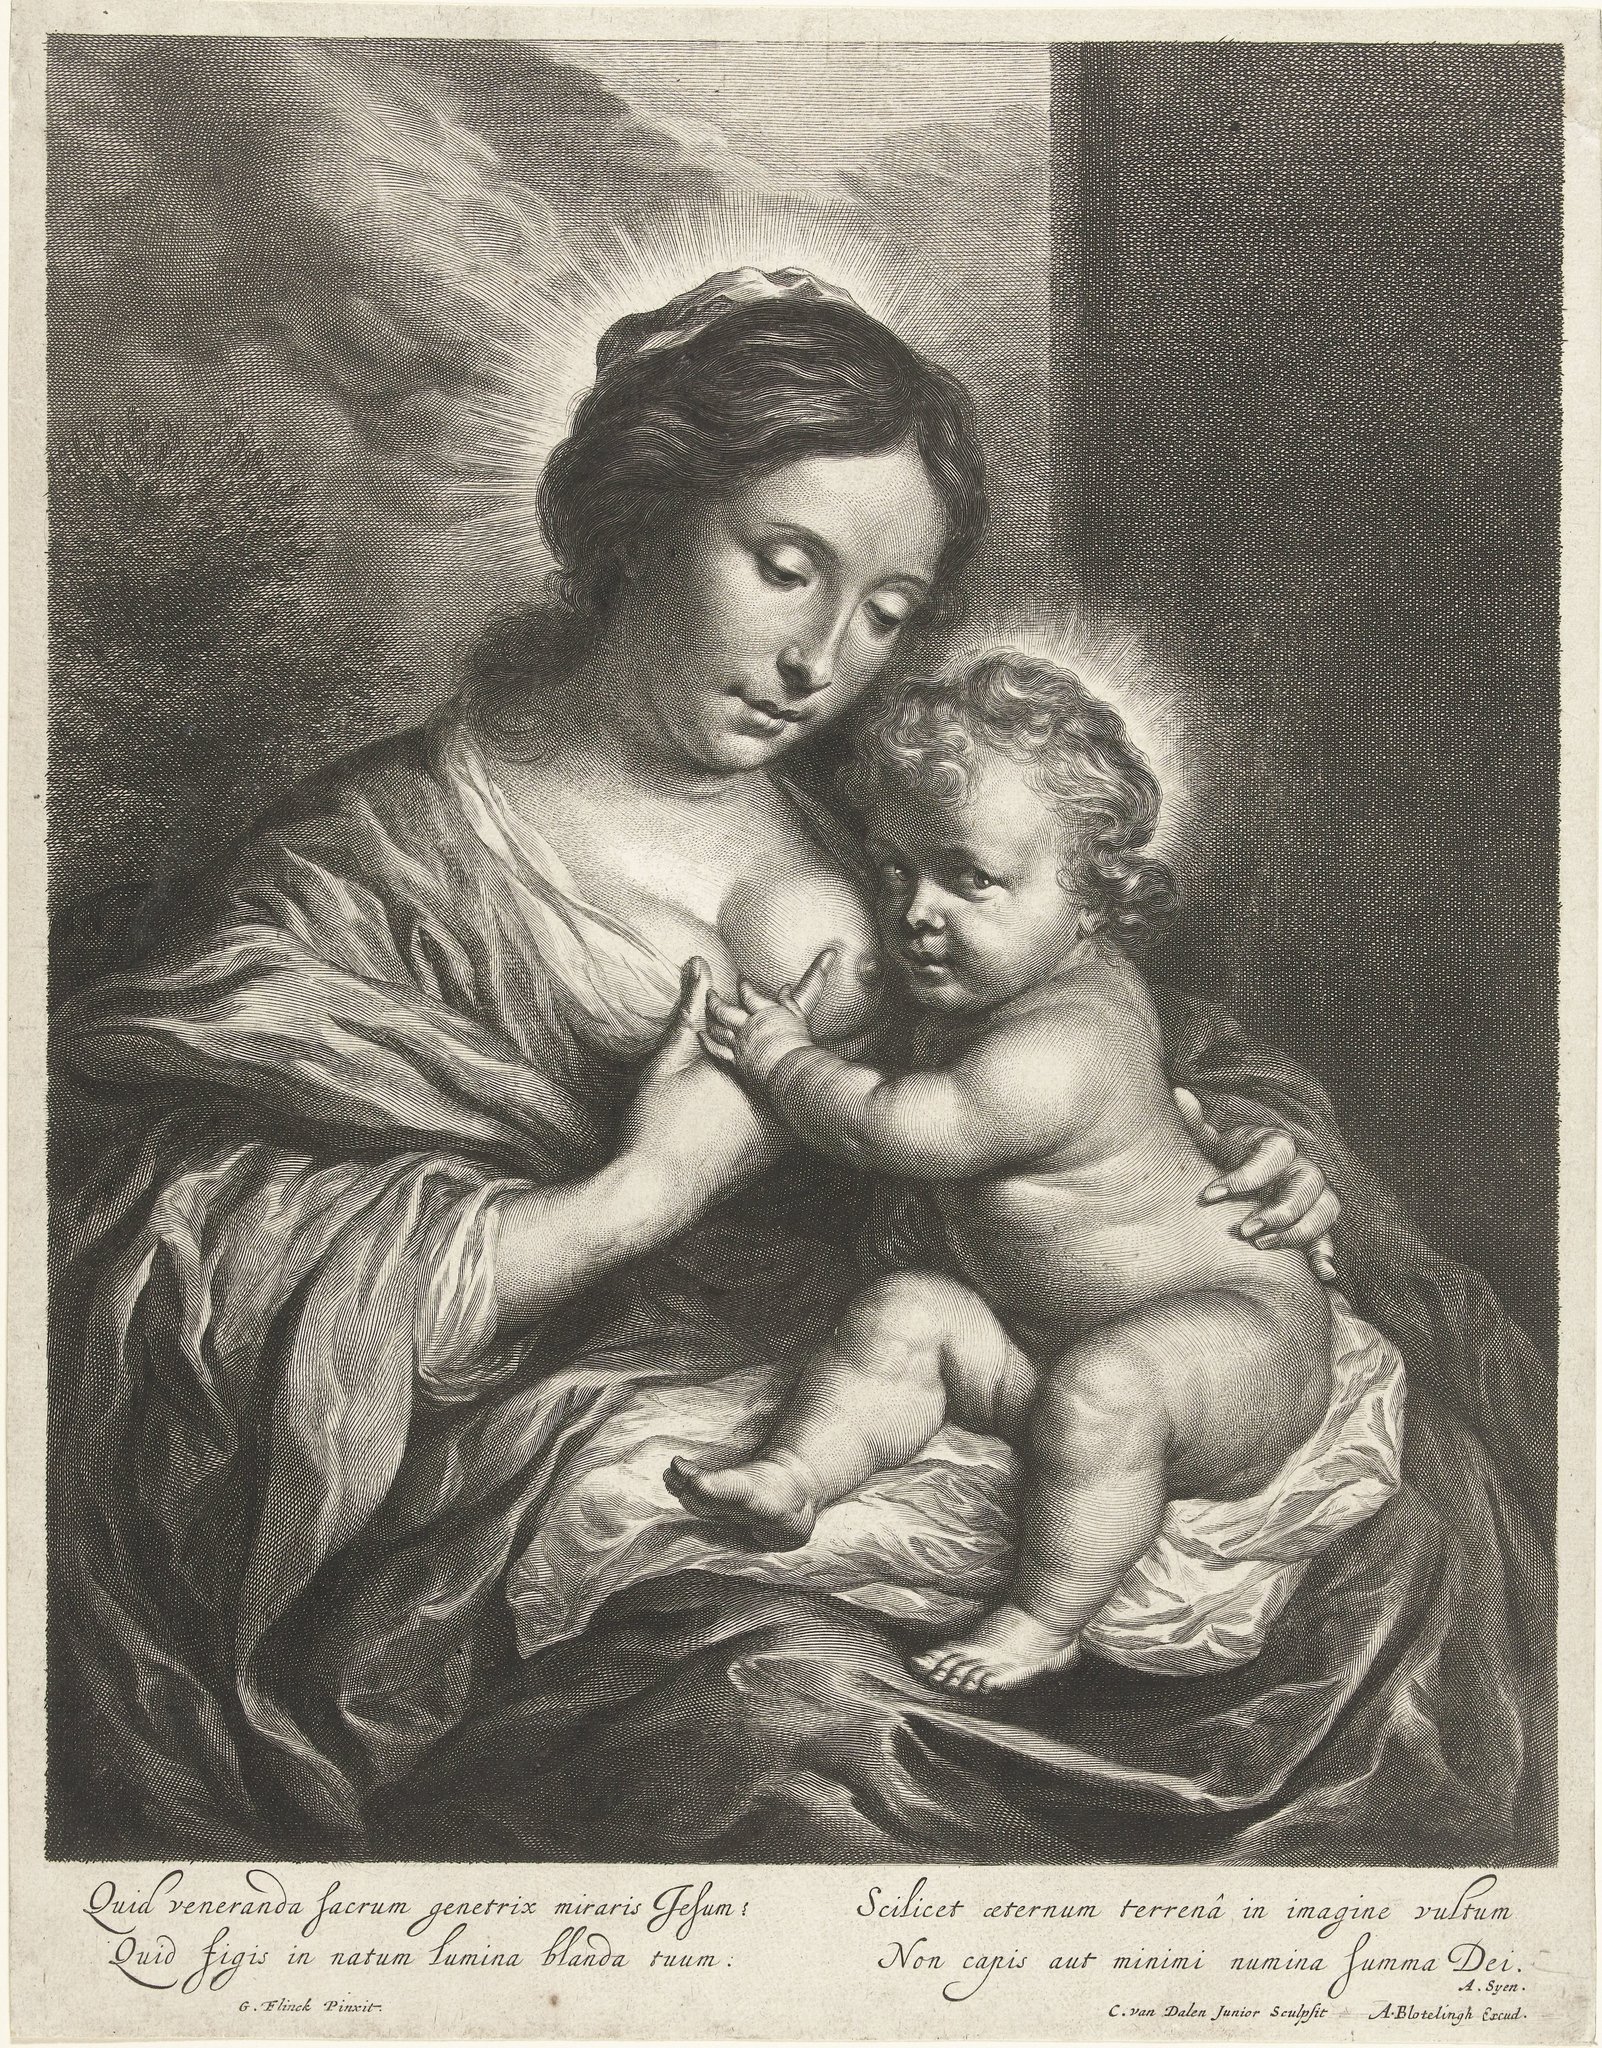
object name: print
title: Maria met het Kind aan de borst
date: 1648-1664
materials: paper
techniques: engraving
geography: amsterdam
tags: 'madonna dell'umiltà' (usually mary suckling the christ-child while sitting on the ground)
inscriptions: collector's mark: Lugt 2228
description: Maria met het Christuskind aan de borst. In ondermarge Latijns vers van A. Syen.